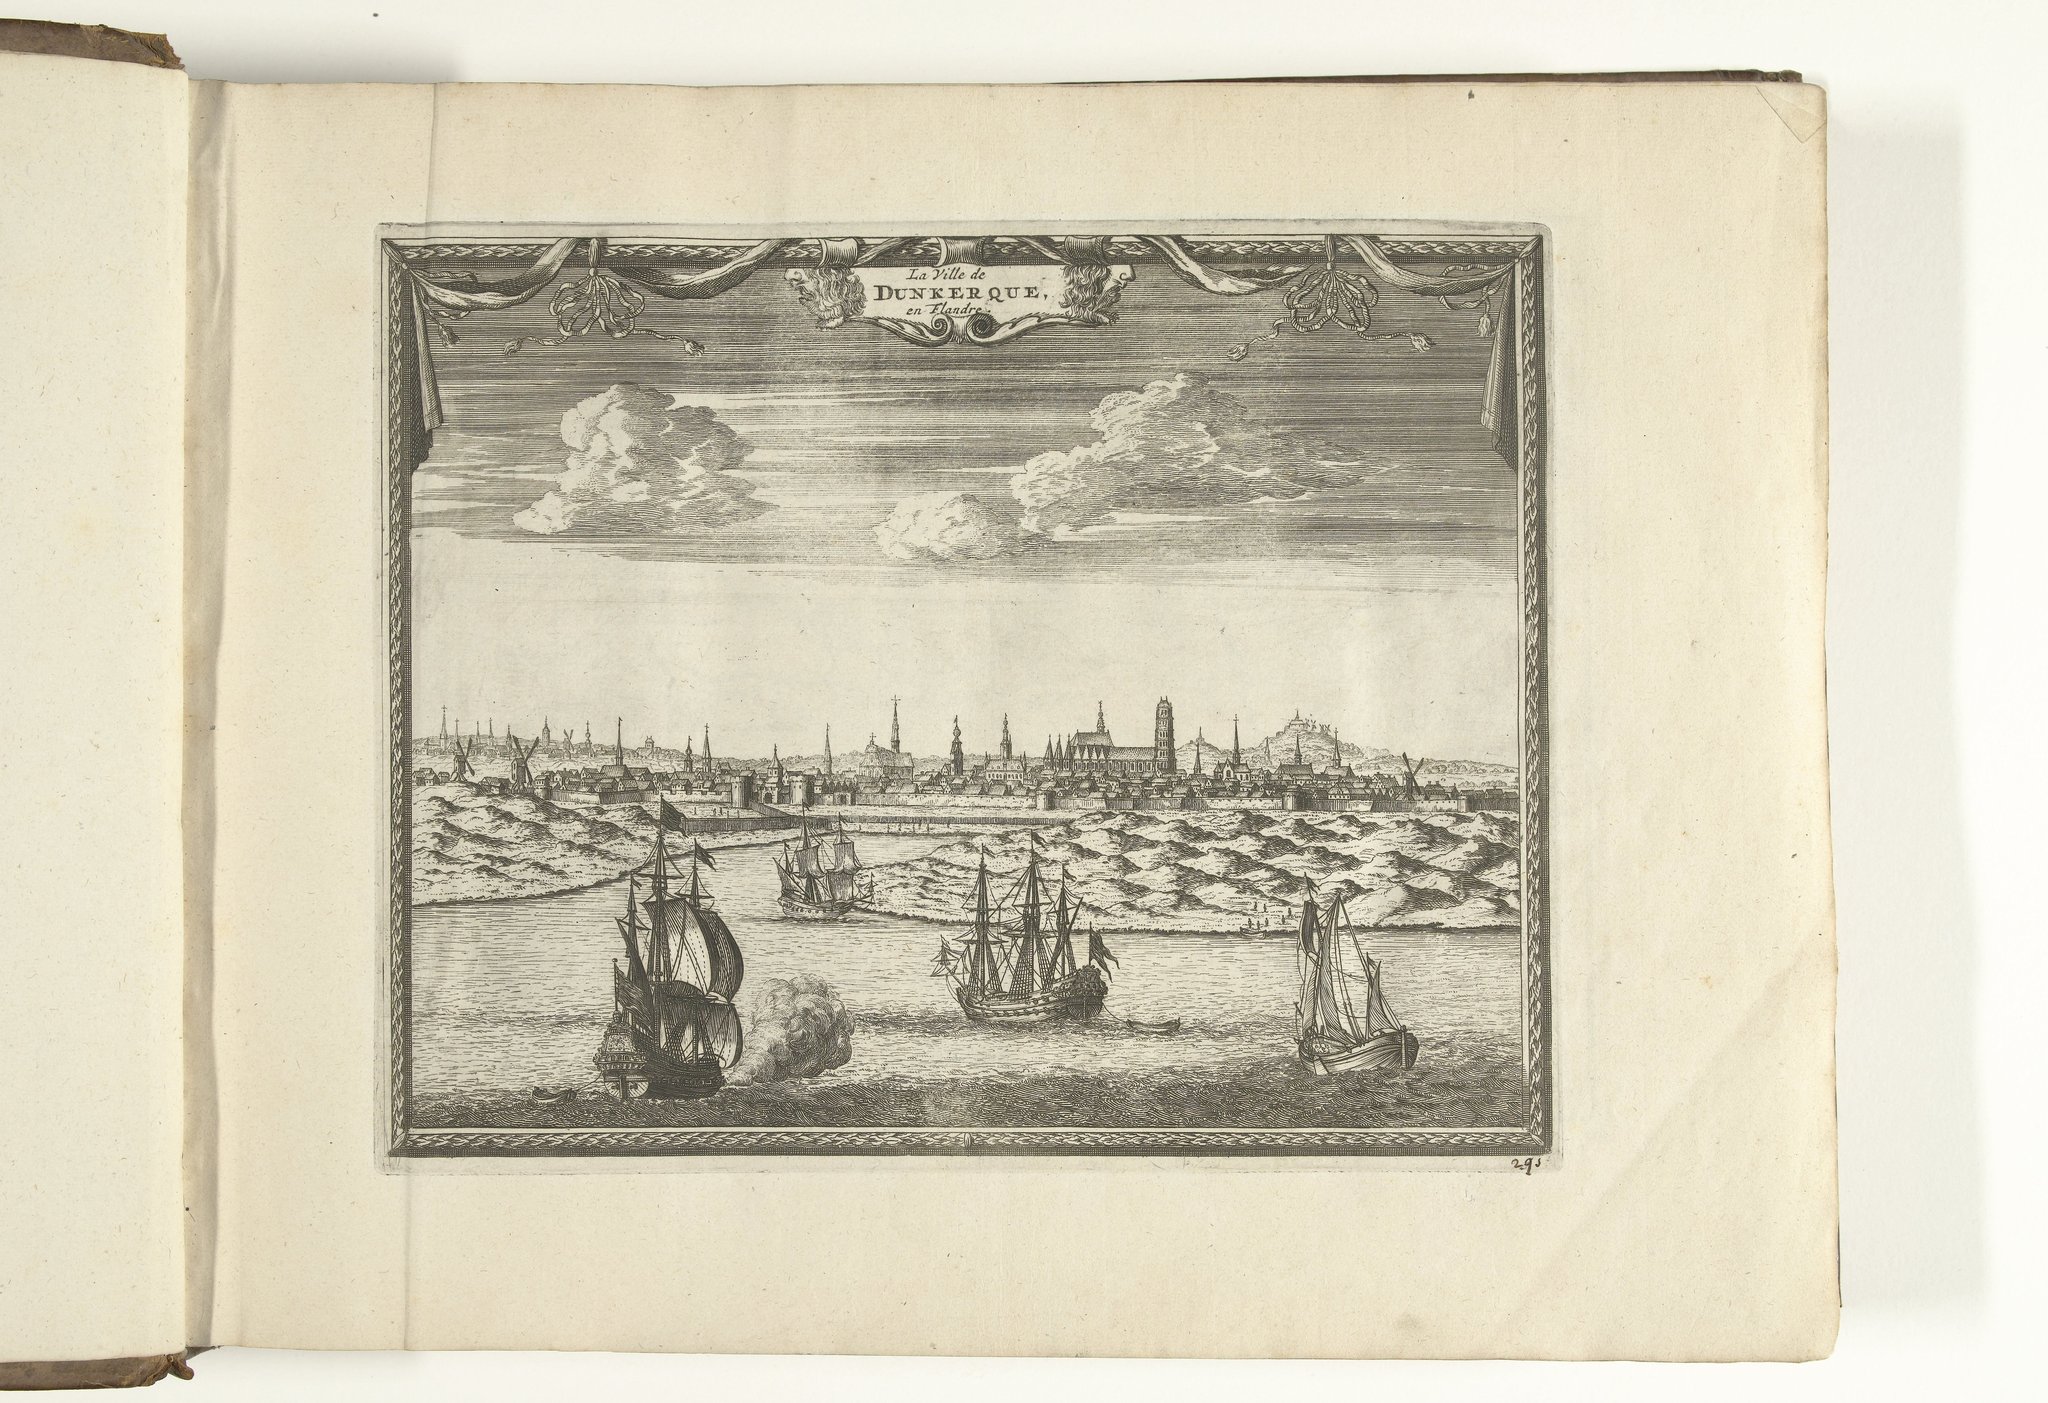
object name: print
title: Les Forces de l'Europe, Asie, Afrique et Amerique (...) Comme aussi les Cartes des Côtes de France et d'Espagne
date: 1726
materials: paper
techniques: etching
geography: leiden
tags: duinkerke, spaanse successieoorlog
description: Gezicht op Duinkerke, op de voorgrond schepen. Plaat nr. 241 in deel XI van het prentwerk: Les Forces de l'Europe, Asie, Afrique et Amerique ... Comme aussi les Cartes des Côtes de France et d'Espagne uit 1726, dit tweede deel met 271 met de hand genummerde platen van vermaarde sterke steden en vestingen in het kader van de Spaanse Successieoorlog 1701-1713. Voor het merendeel zijn deze platen gekopieerd naar de anonieme Franse platen van vermaarde sterke steden en vestingen: in Les forces de l'Europe en in: Le theatre de la guerre, dans les Pays-Bas, beide oorspronkelijk uitgegeven door Nicolas de Fer te Parijs (1693-1697) in het kader van de Negenjarige Oorlog. Titel in het Frans.